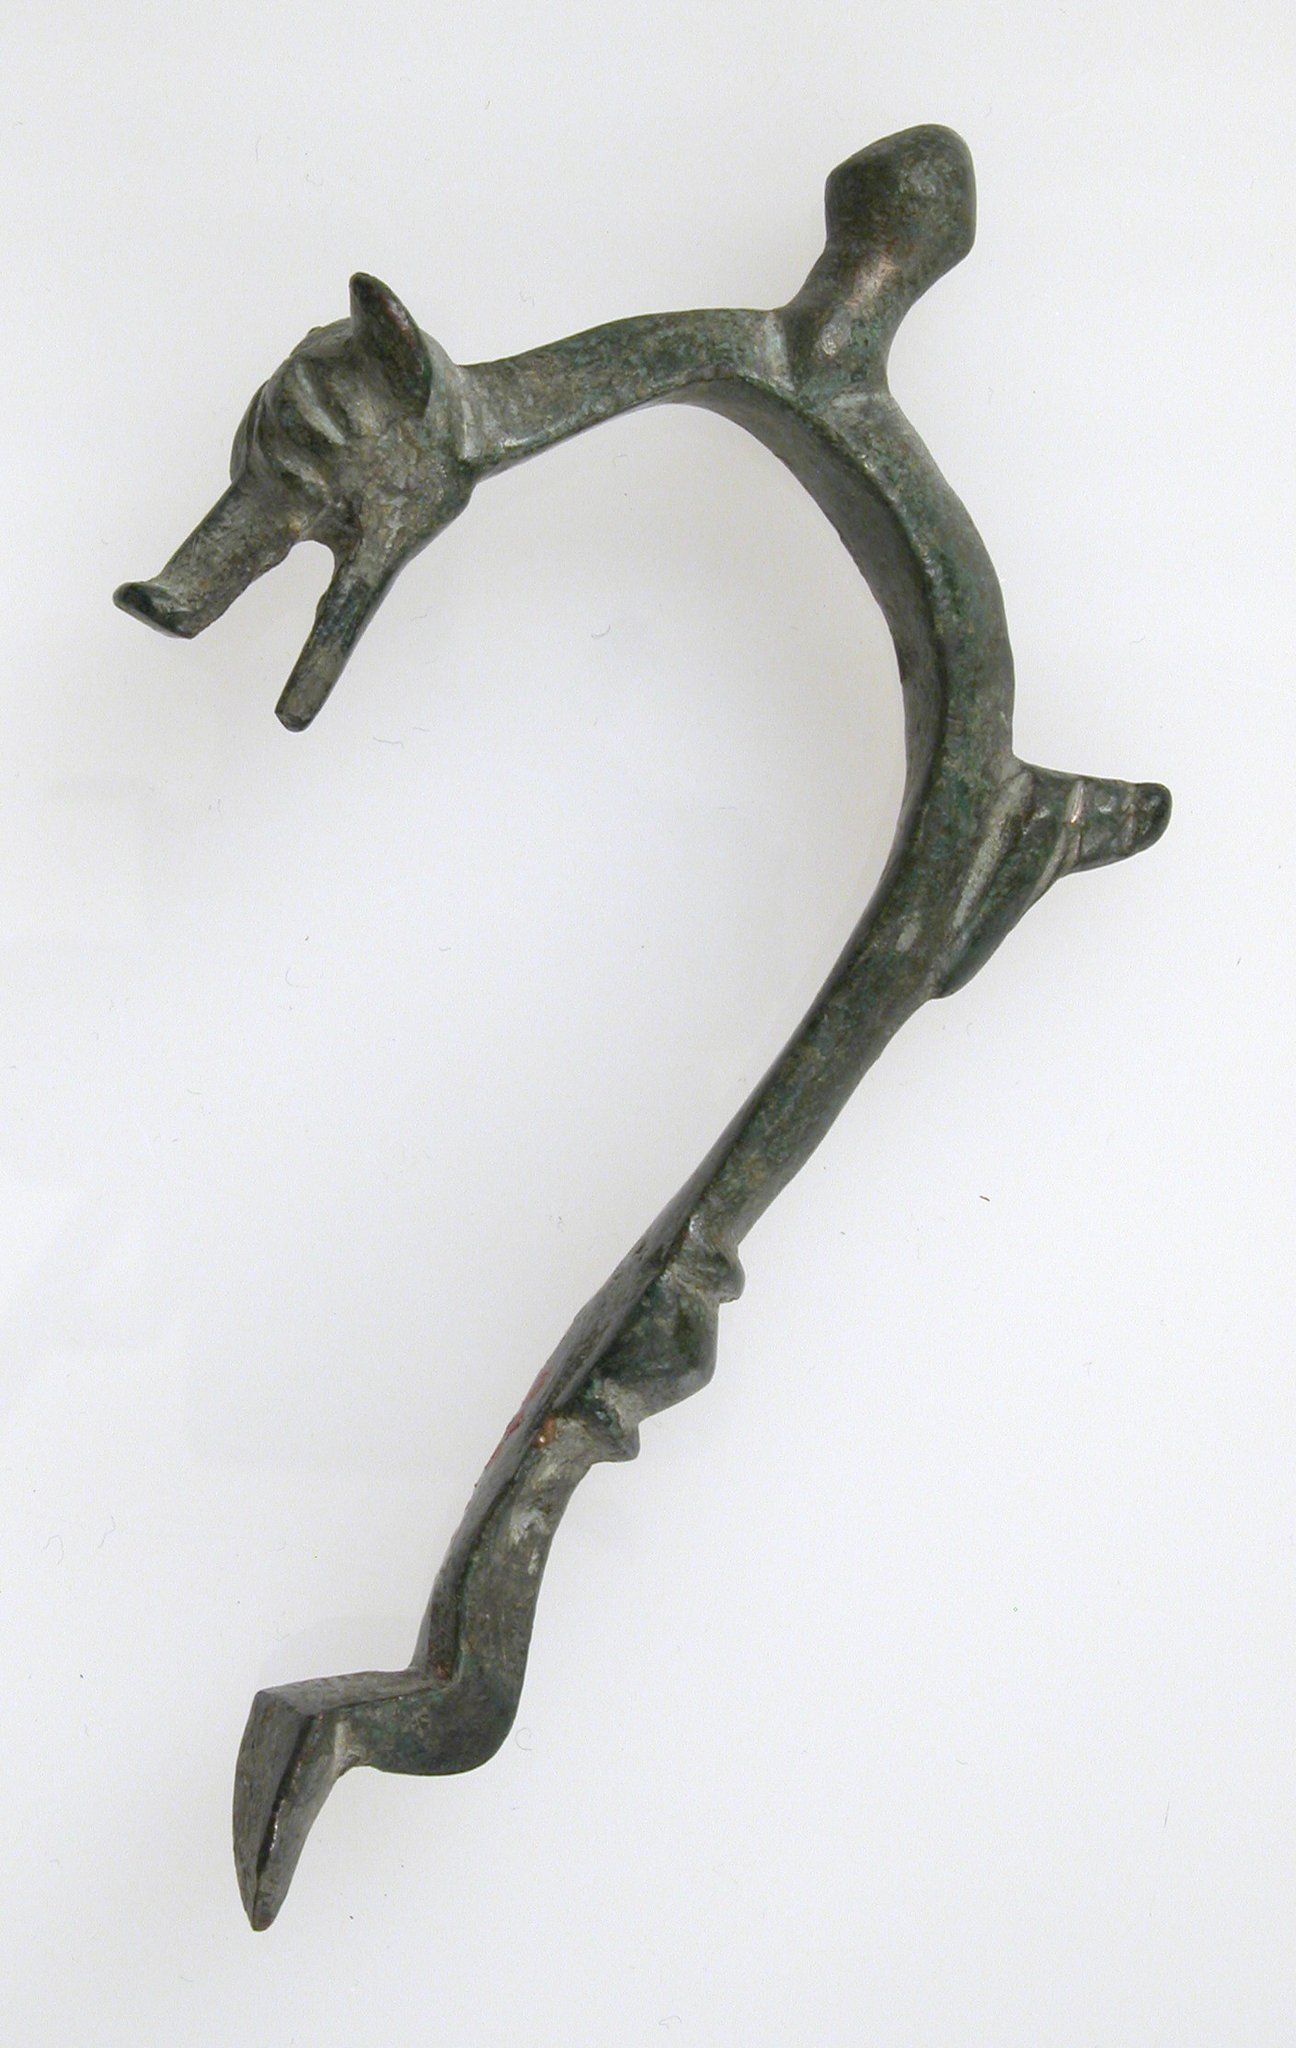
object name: handle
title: Handle of Ewer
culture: celtic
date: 500-401 BCE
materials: copper alloy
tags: dogs